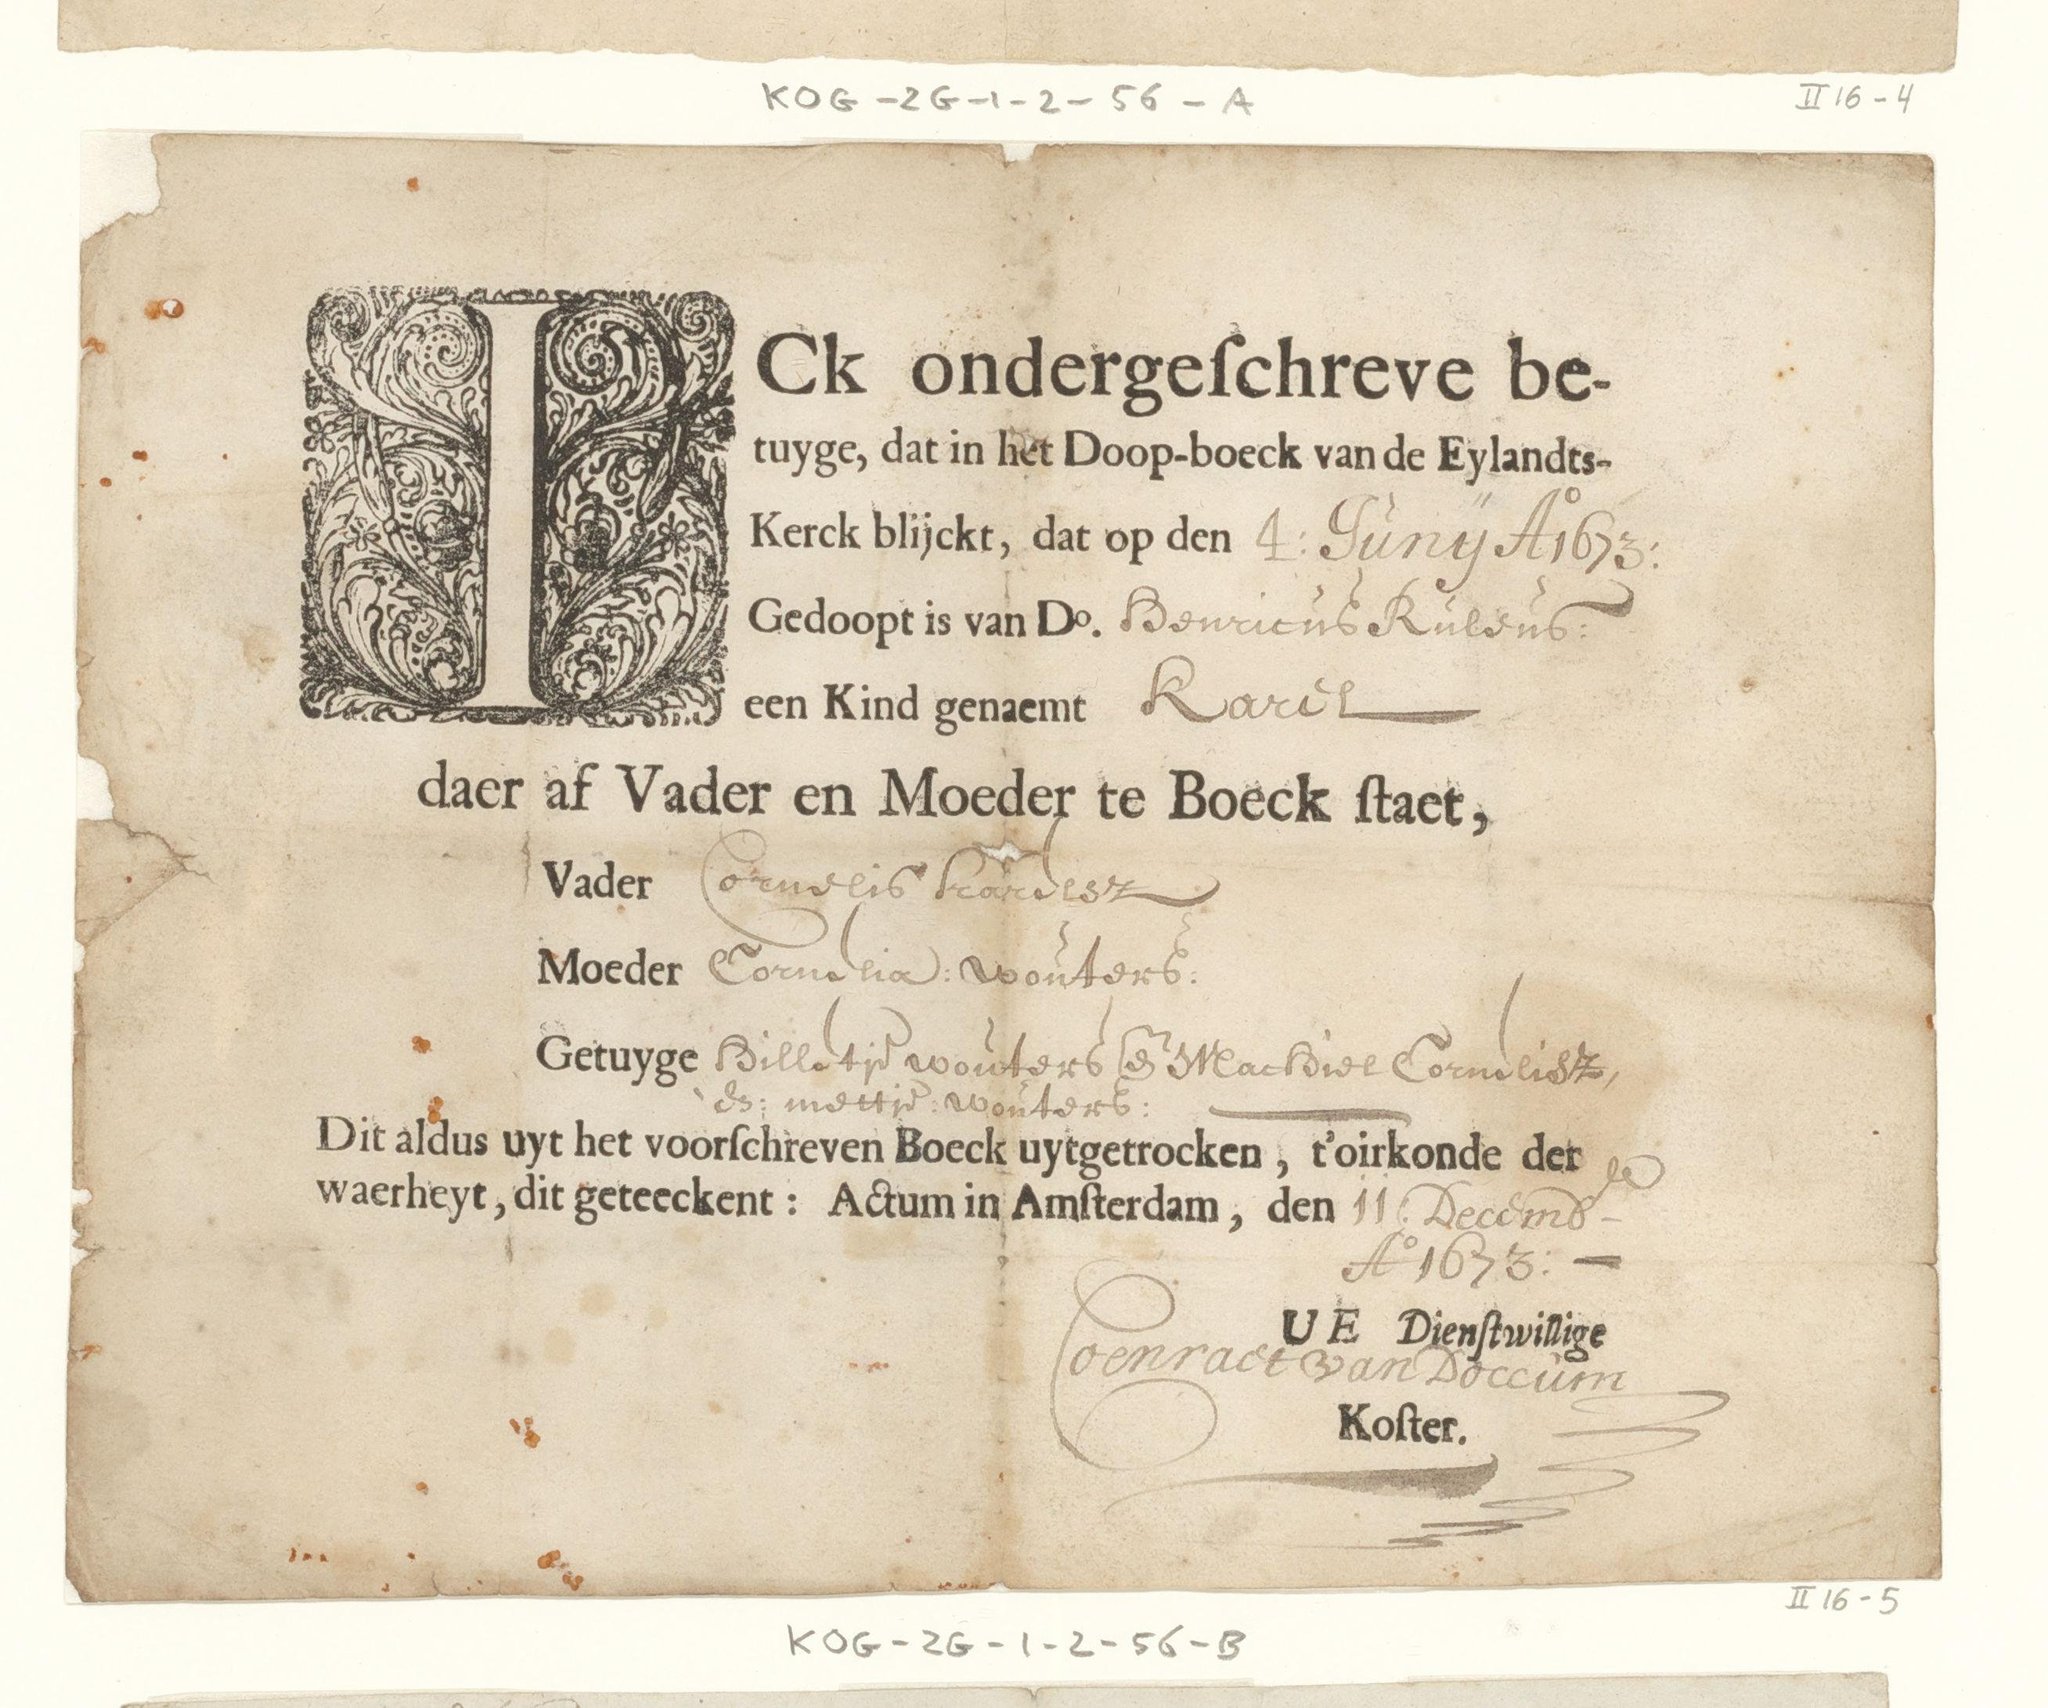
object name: document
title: Uittreksel uit het doopregister van de Eylandts-Kerck, 1673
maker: Anonymous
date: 1673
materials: ink, paper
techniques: letterpress printing, pen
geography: amsterdam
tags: registration bureau, civil registry, baptism ~ protestant service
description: Doopceel, uittreksel uit het doopregister van de Eylandts-Kerck (Eilandskerk) te Amsterdam, van 11 december 1673, van de doop op 4 juni 1673 van het kind Karel, kind van Cornelis Karelsz en Cornelia Wouters. Voorgedrukt formulier met de hand met pen ingevuld. Onderwerpsrubrieken binnen de Atlas Zeden en Gewoonten: Regeering, Burgerlijke Stand.